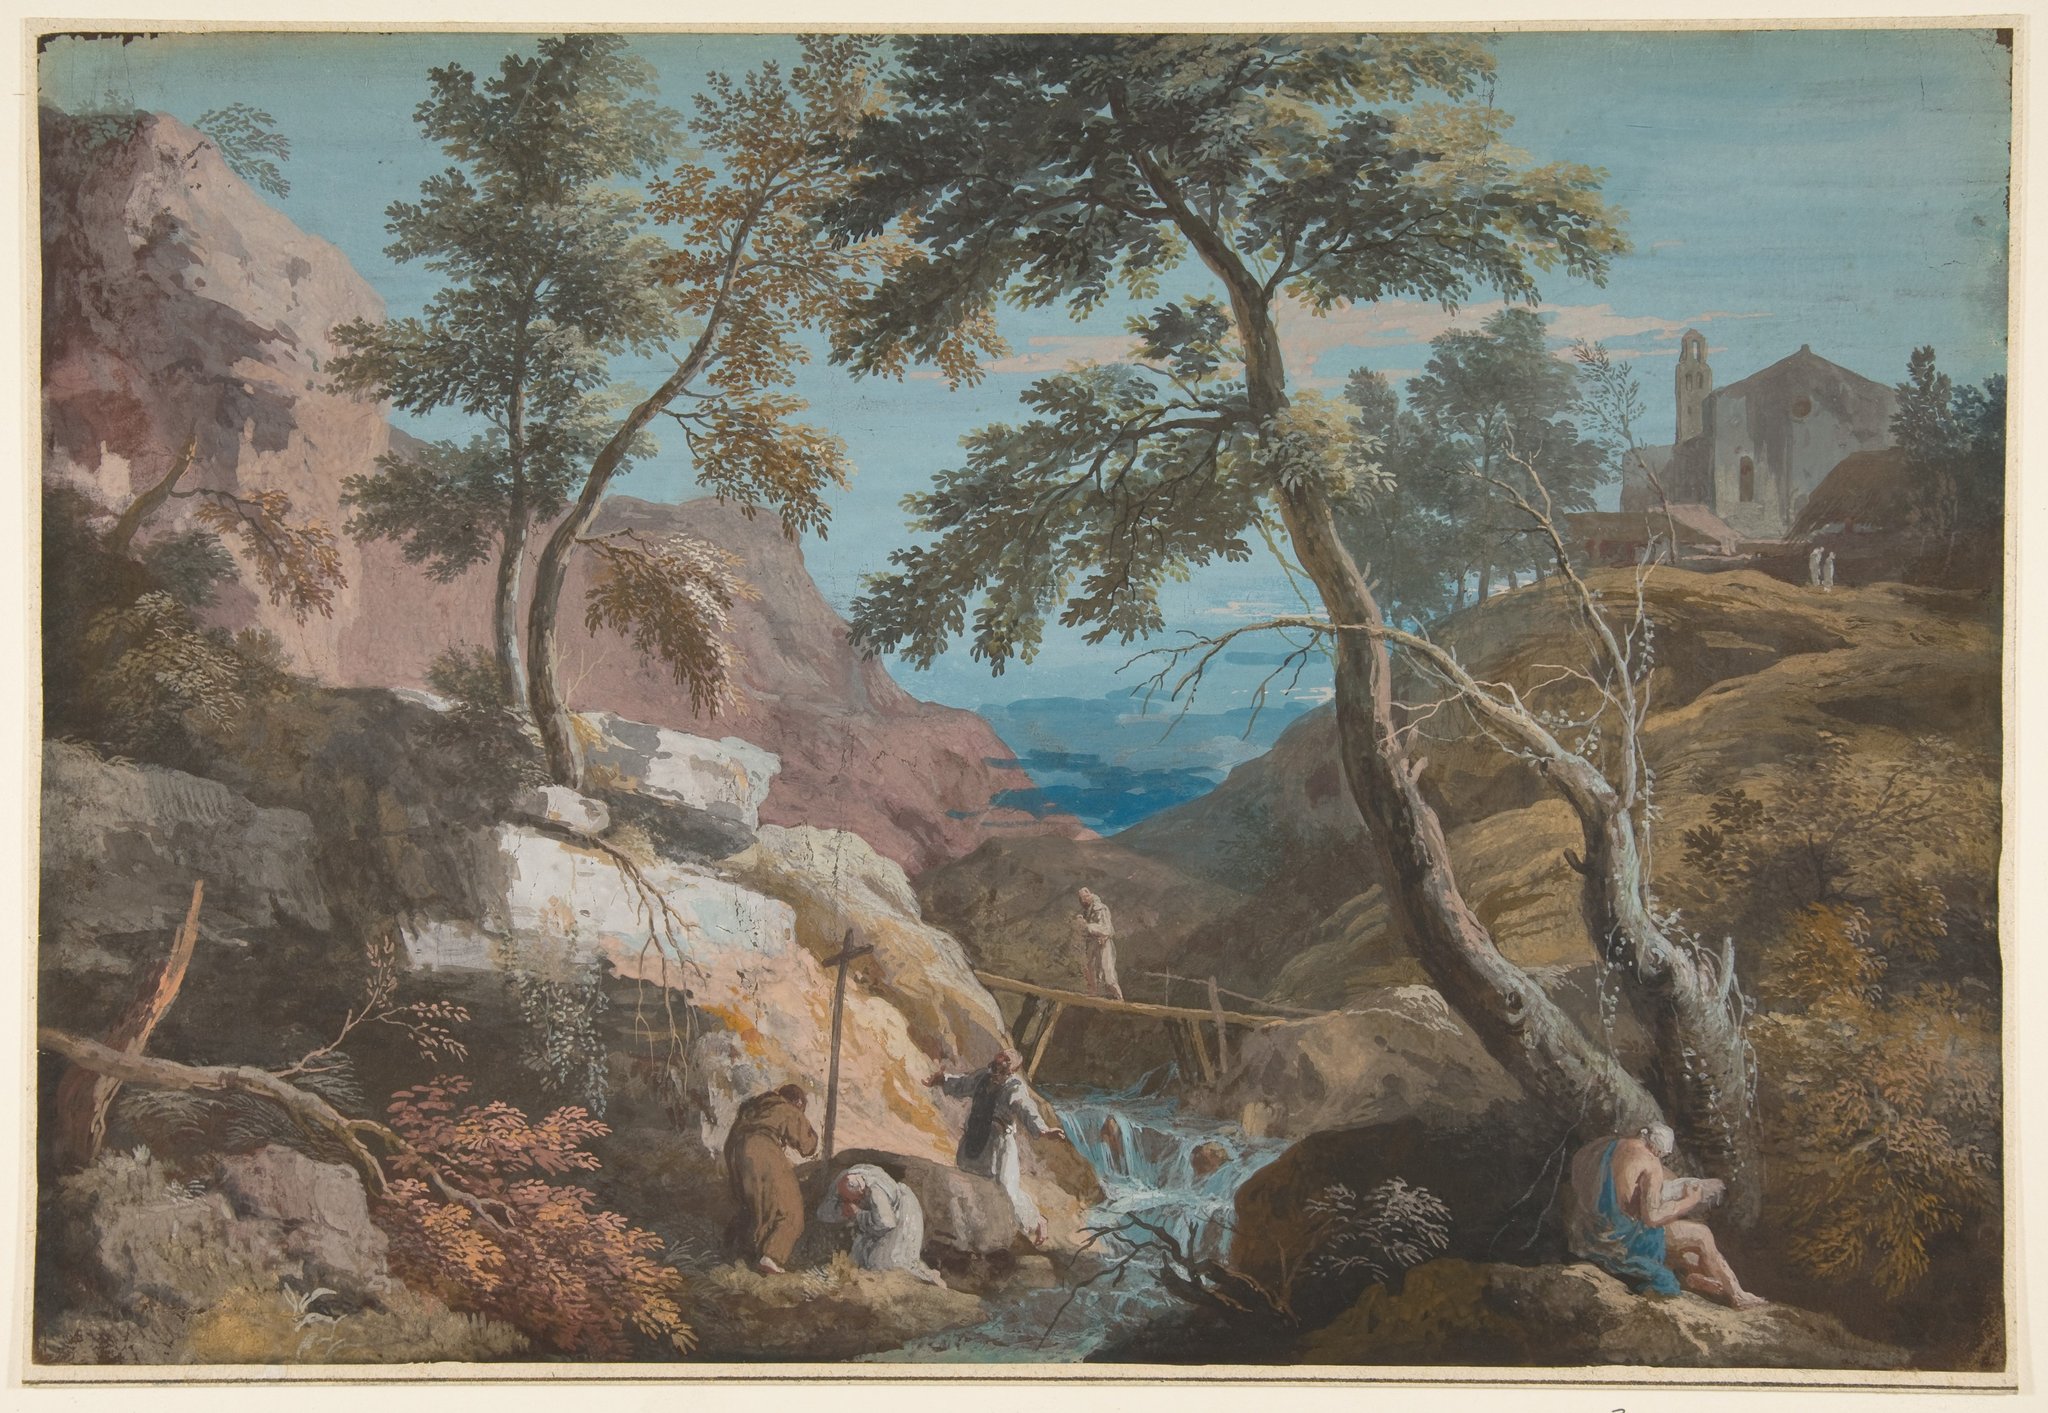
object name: drawing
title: Mountainous Landscape with Hermits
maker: marco ricci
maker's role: artist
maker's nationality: italian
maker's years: 1676-1730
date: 1676-1730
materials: gouache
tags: men,mountains,landscapes,cross